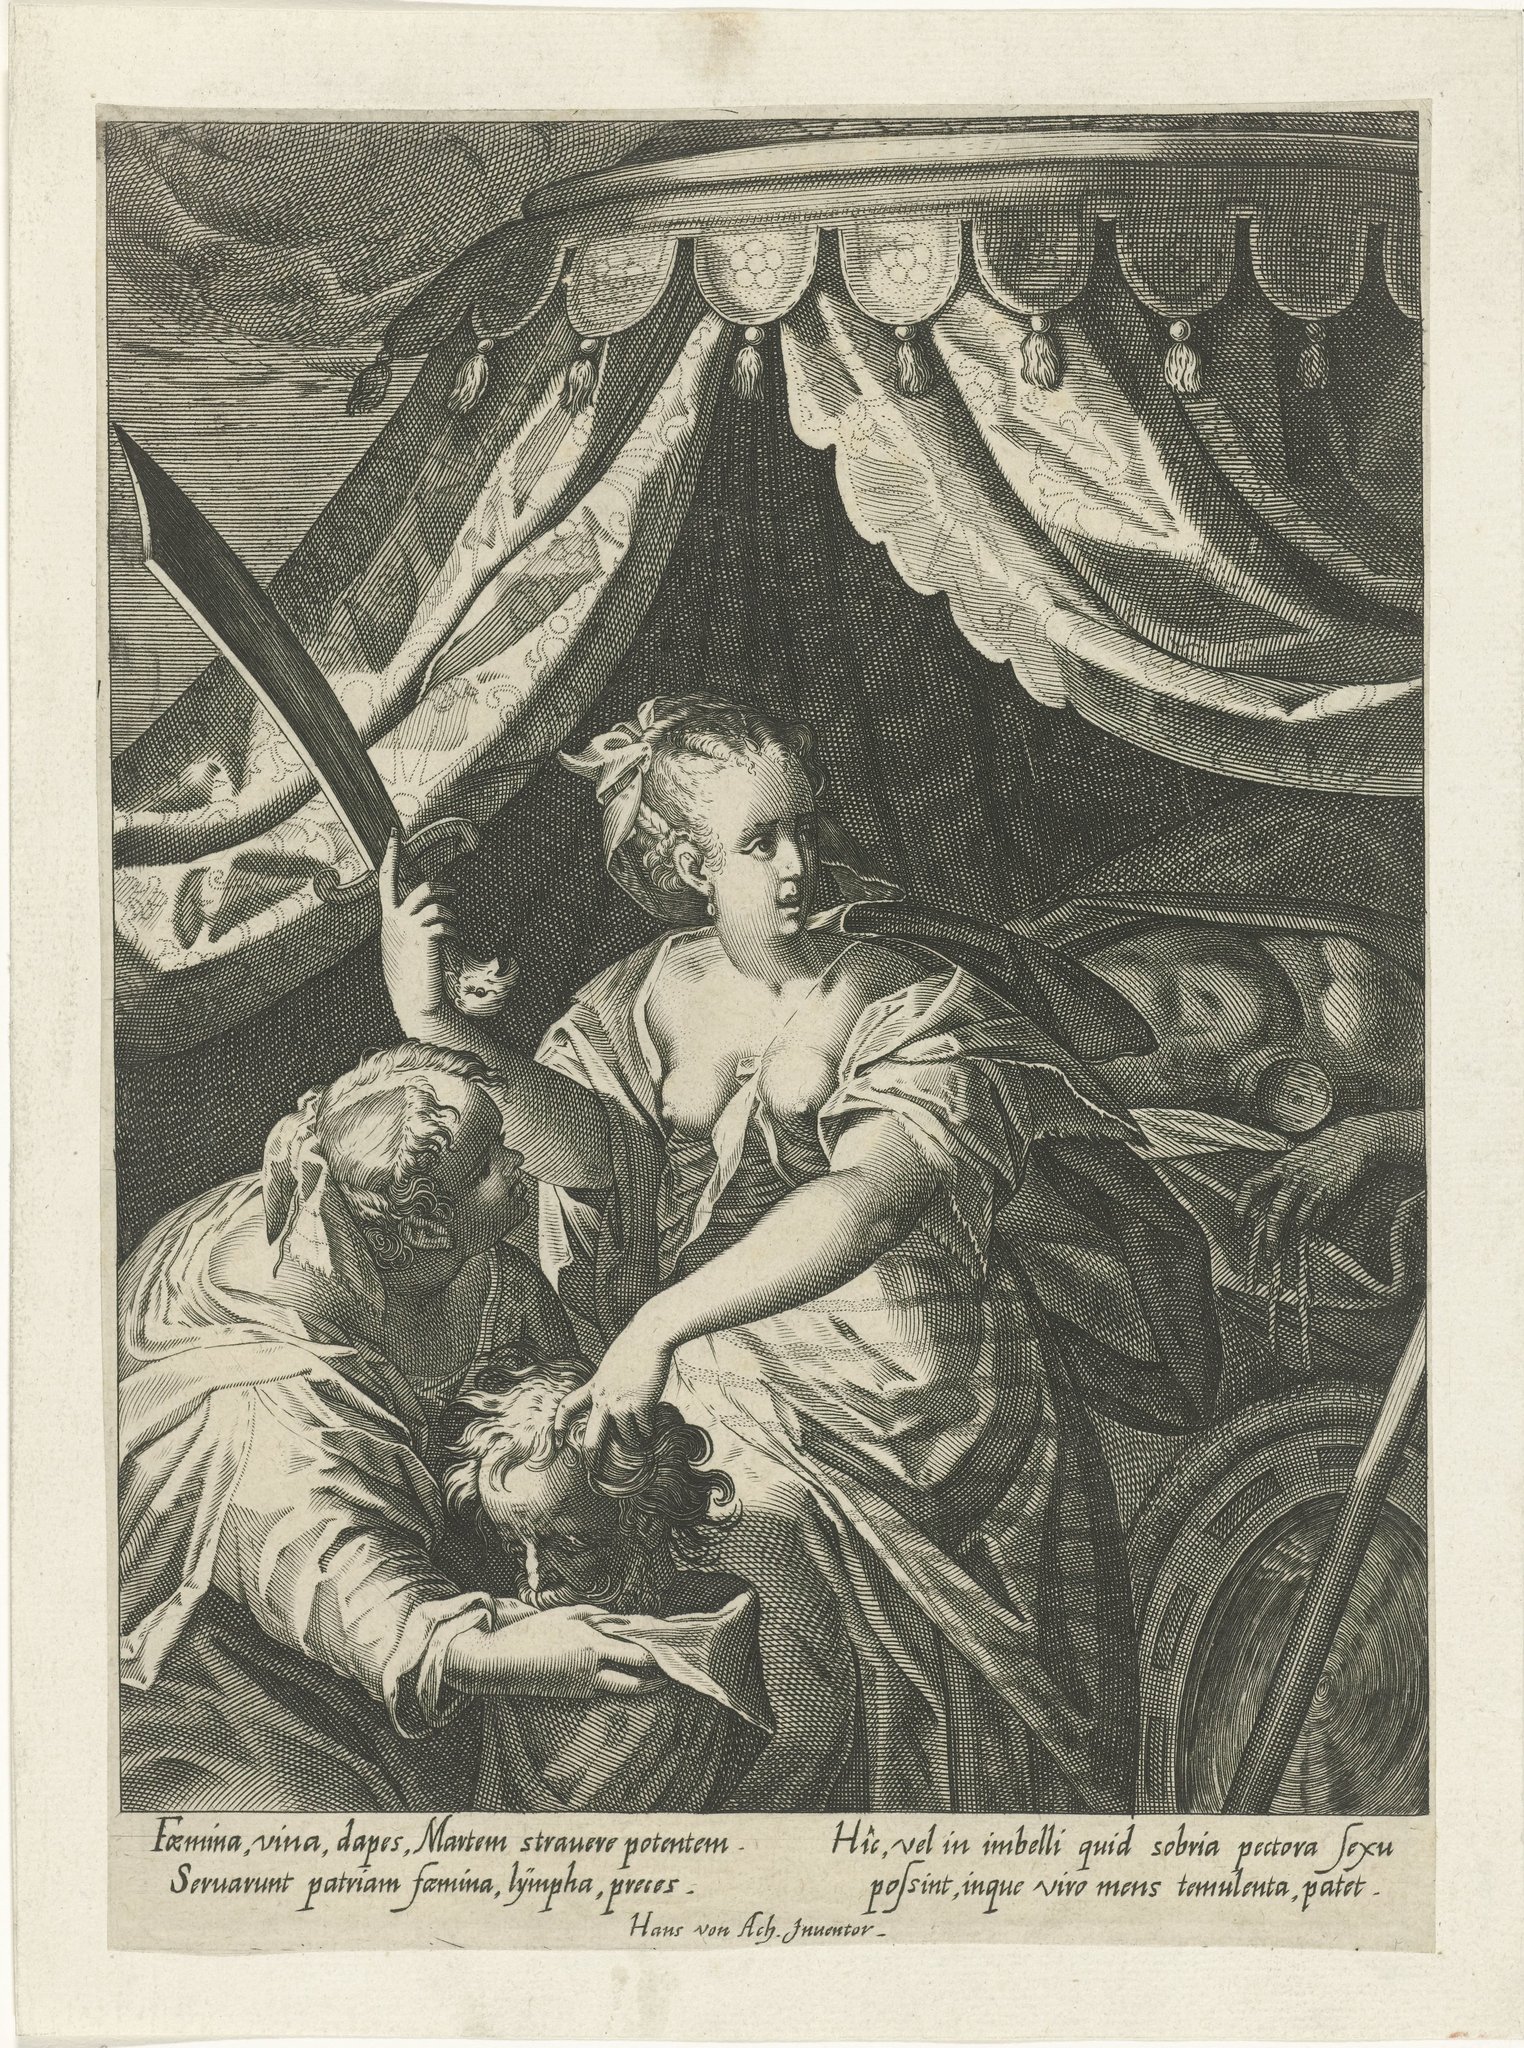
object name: print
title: Judit met het hoofd van Holofernes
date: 1580-1679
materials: paper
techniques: engraving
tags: judith and her maidservant put holofernes' head in a sack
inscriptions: collector's mark: Lugt 240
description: Judit stopt het hoofd van Holofernes in een zak, die wordt open gehouden door haar dienstmaagd. In haar rechterhand het zwaard. Achter haar de onthoofde Holofernes in zijn tent. De prent heeft een Latijns onderschrift.